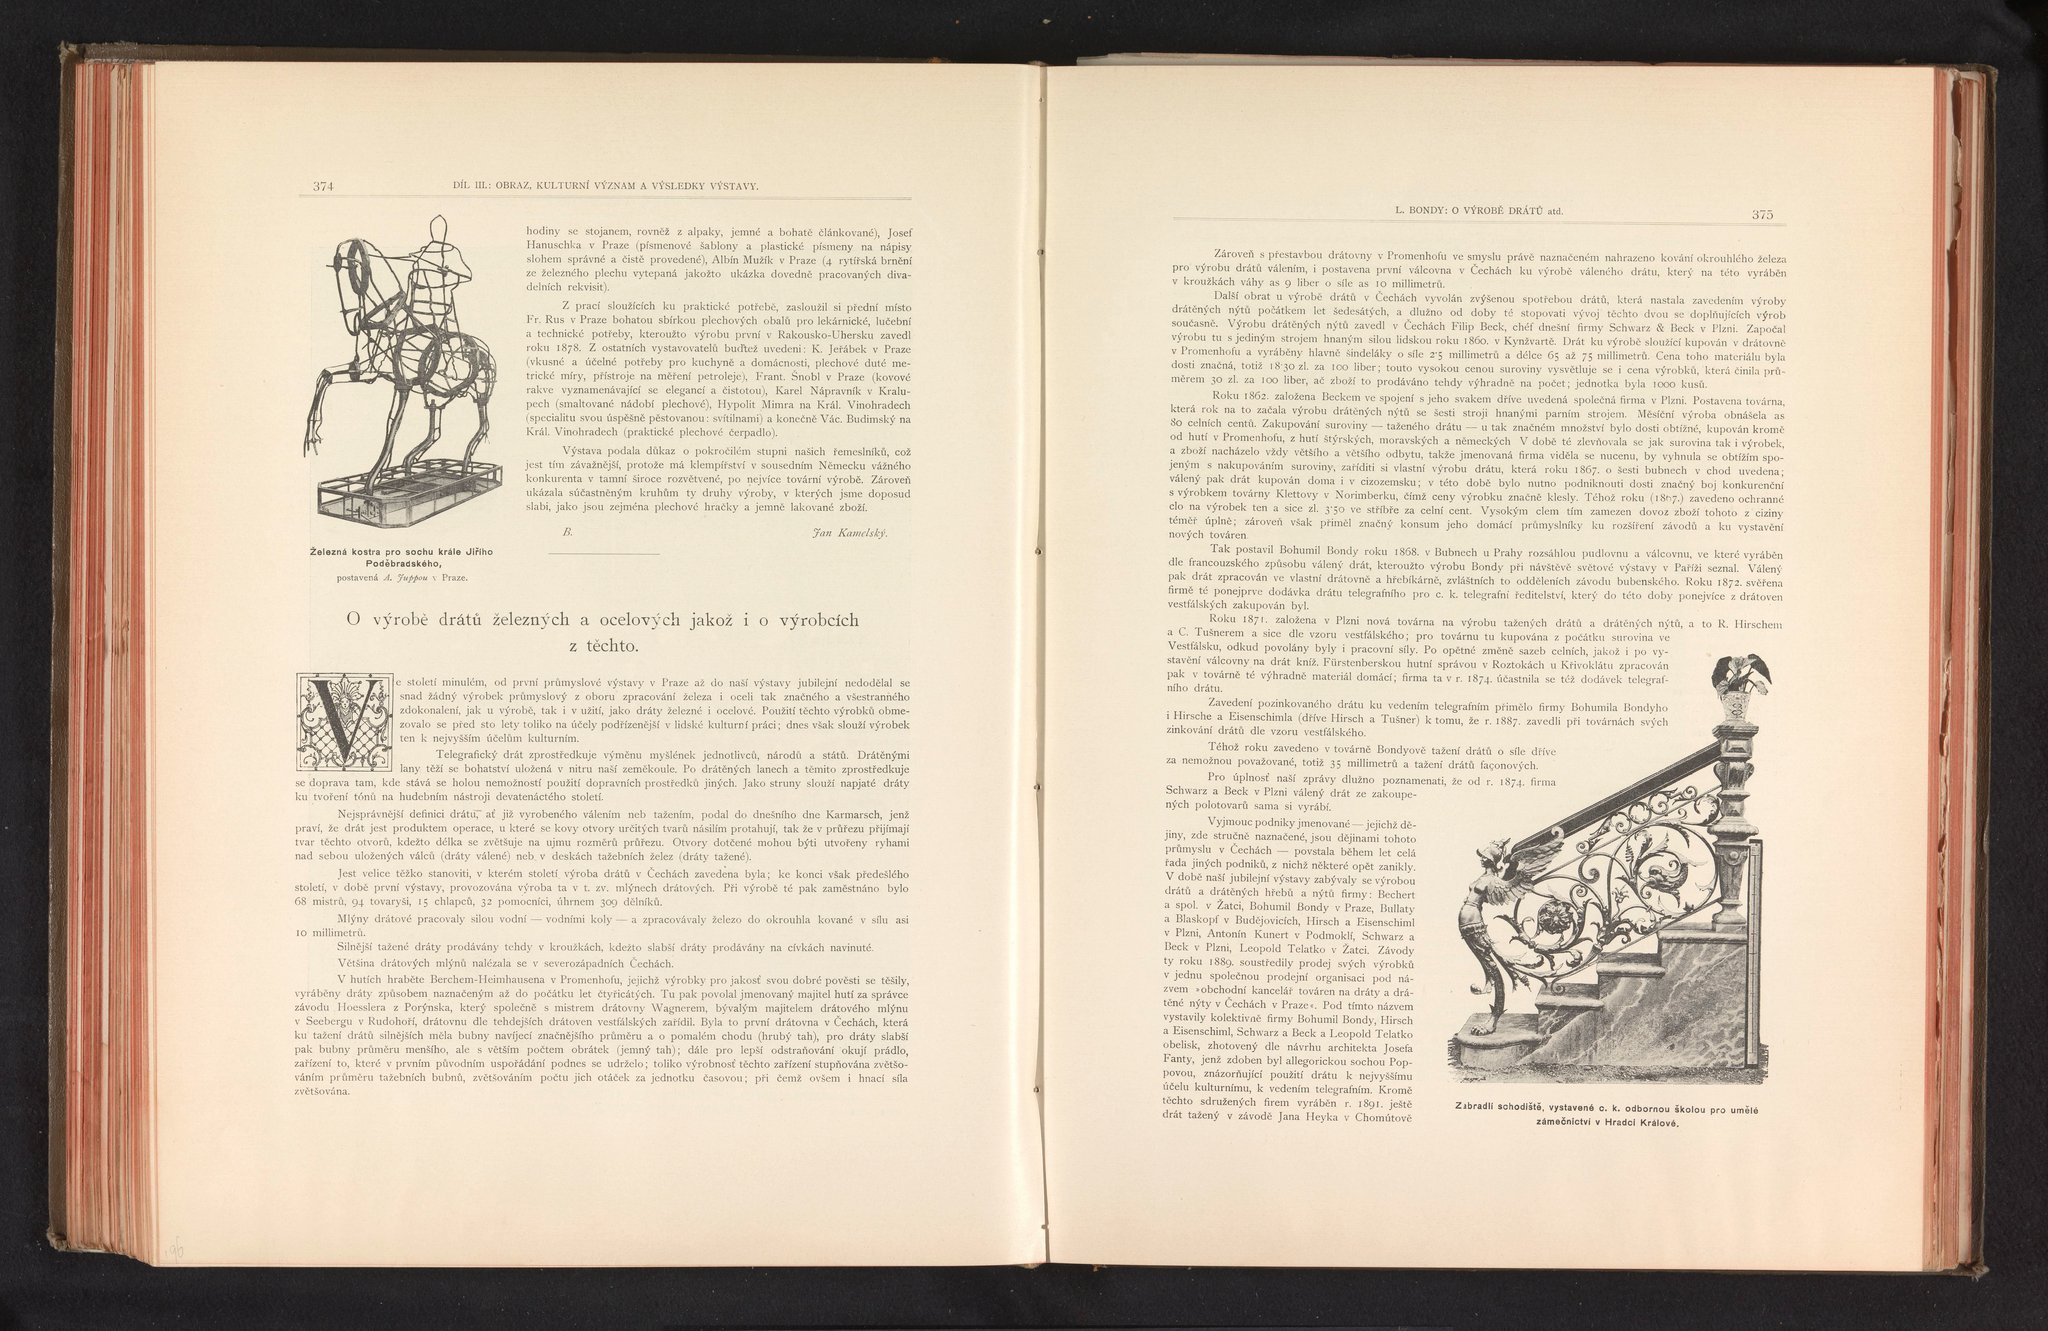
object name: page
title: Zelezná kostra pro sochu krále Jiriho Podebradského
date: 1890-1895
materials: paper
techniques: autotype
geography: prague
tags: equestrian statue